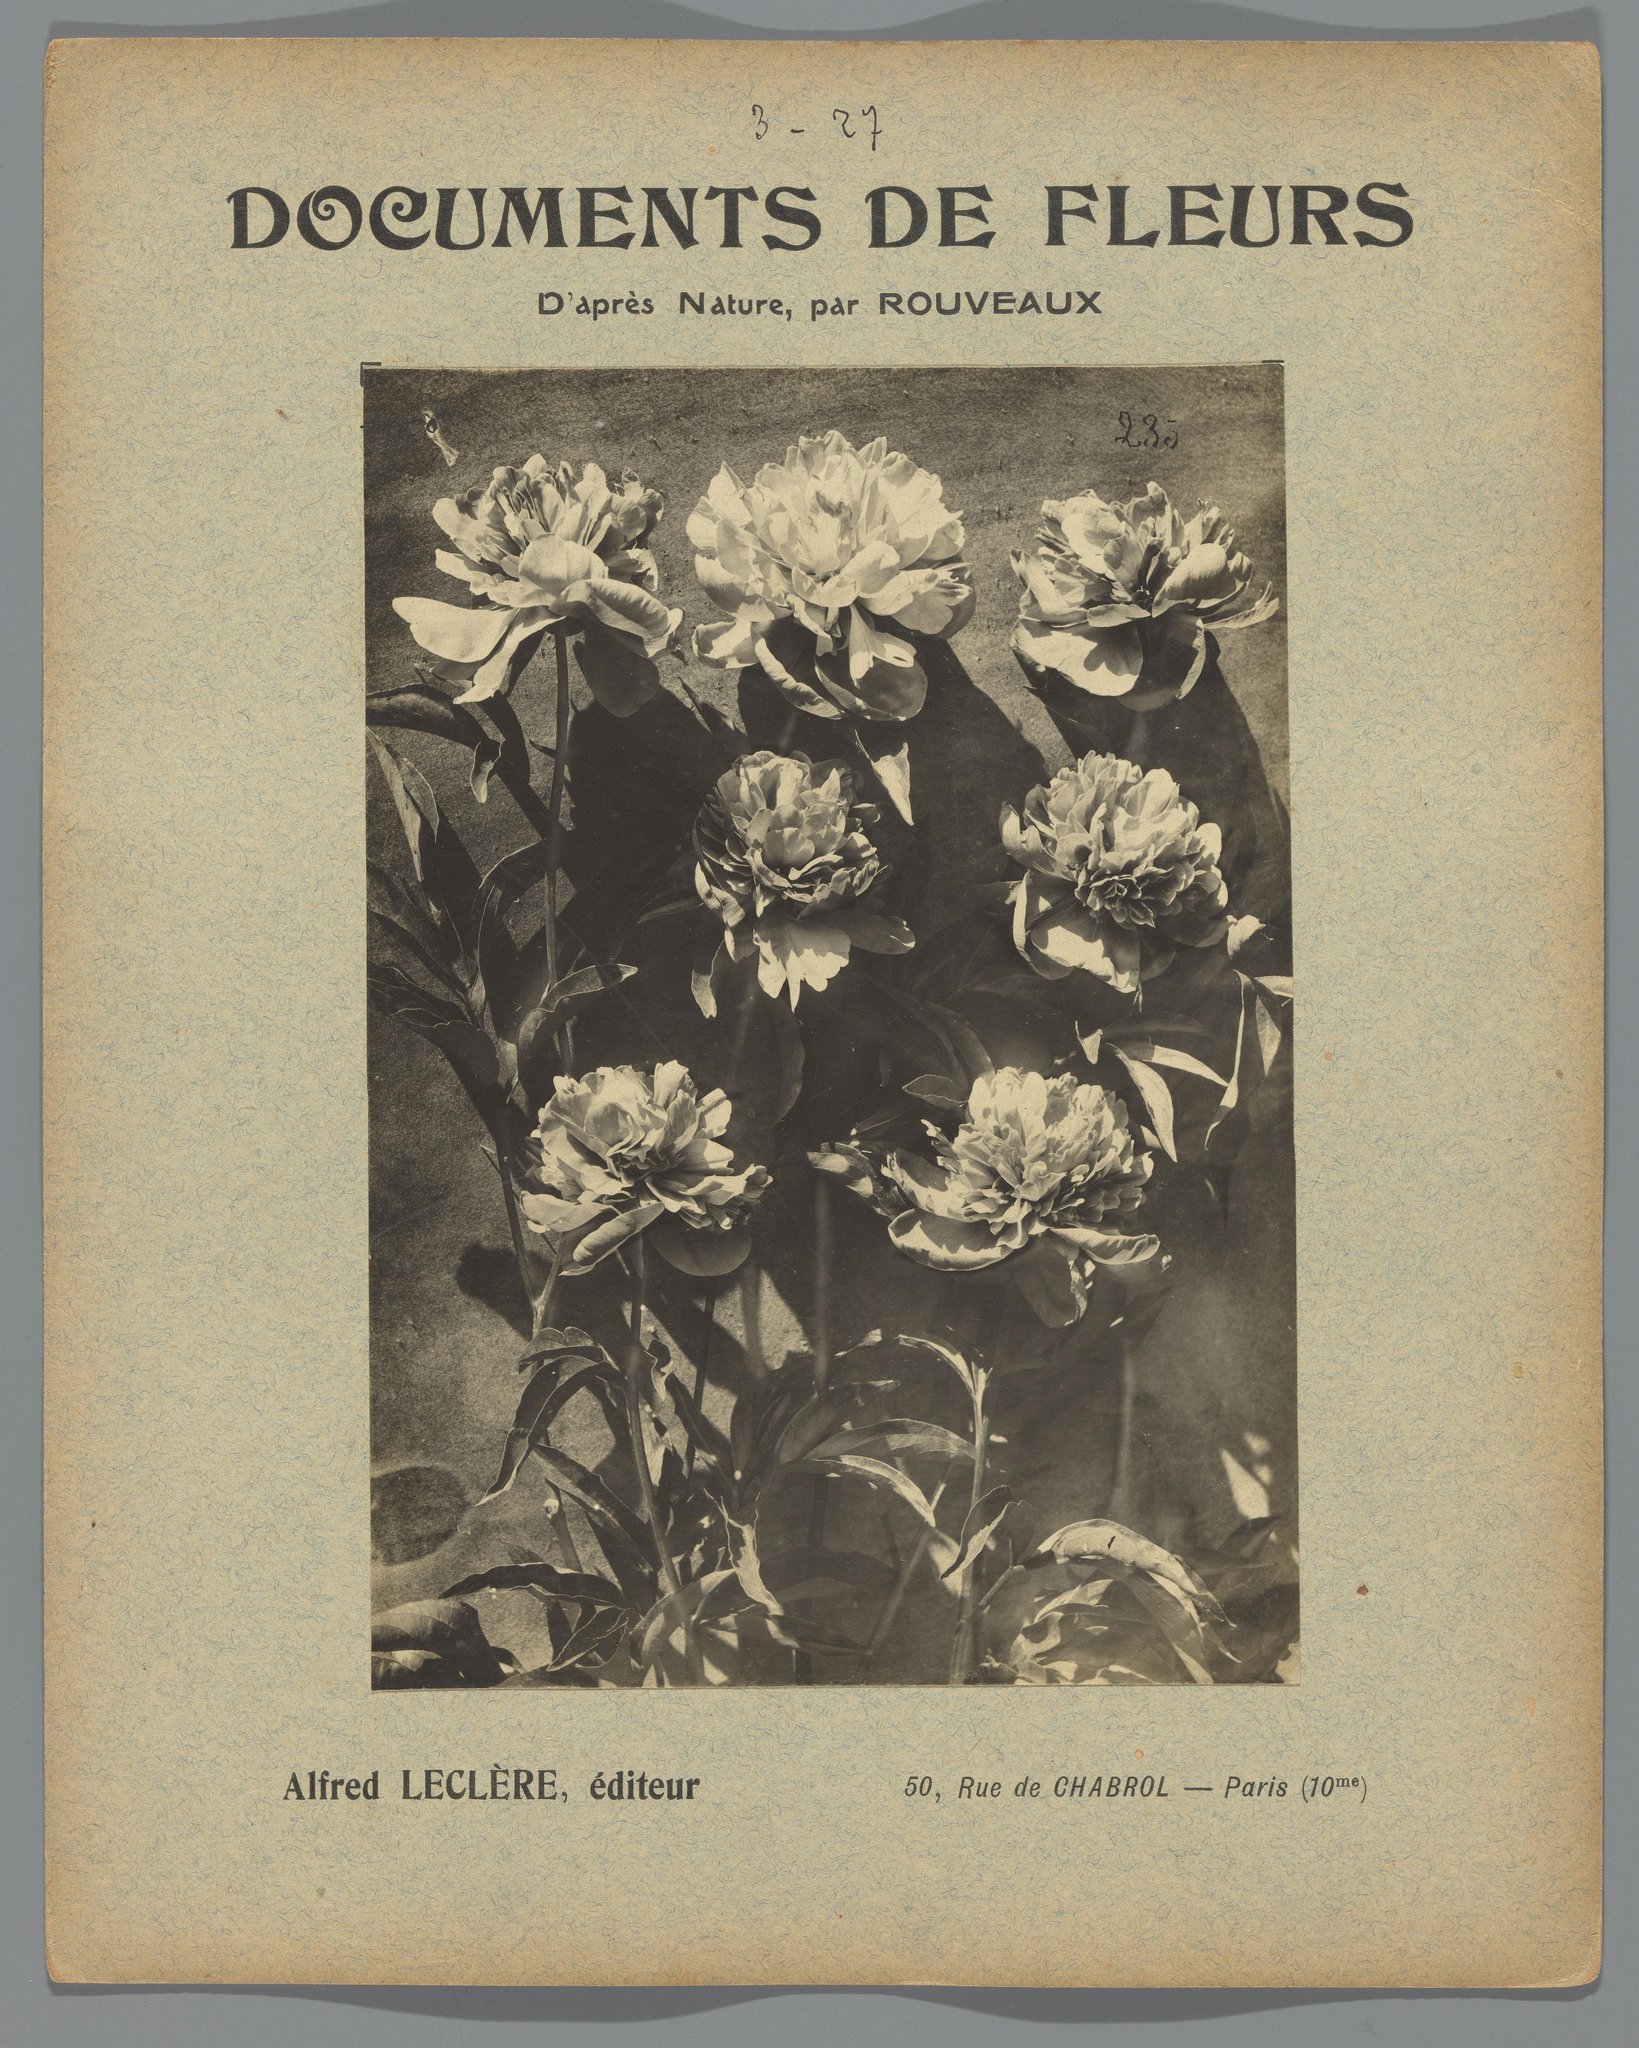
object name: photograph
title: Bloemstudie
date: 1895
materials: photographic support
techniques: gelatin silver print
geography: france